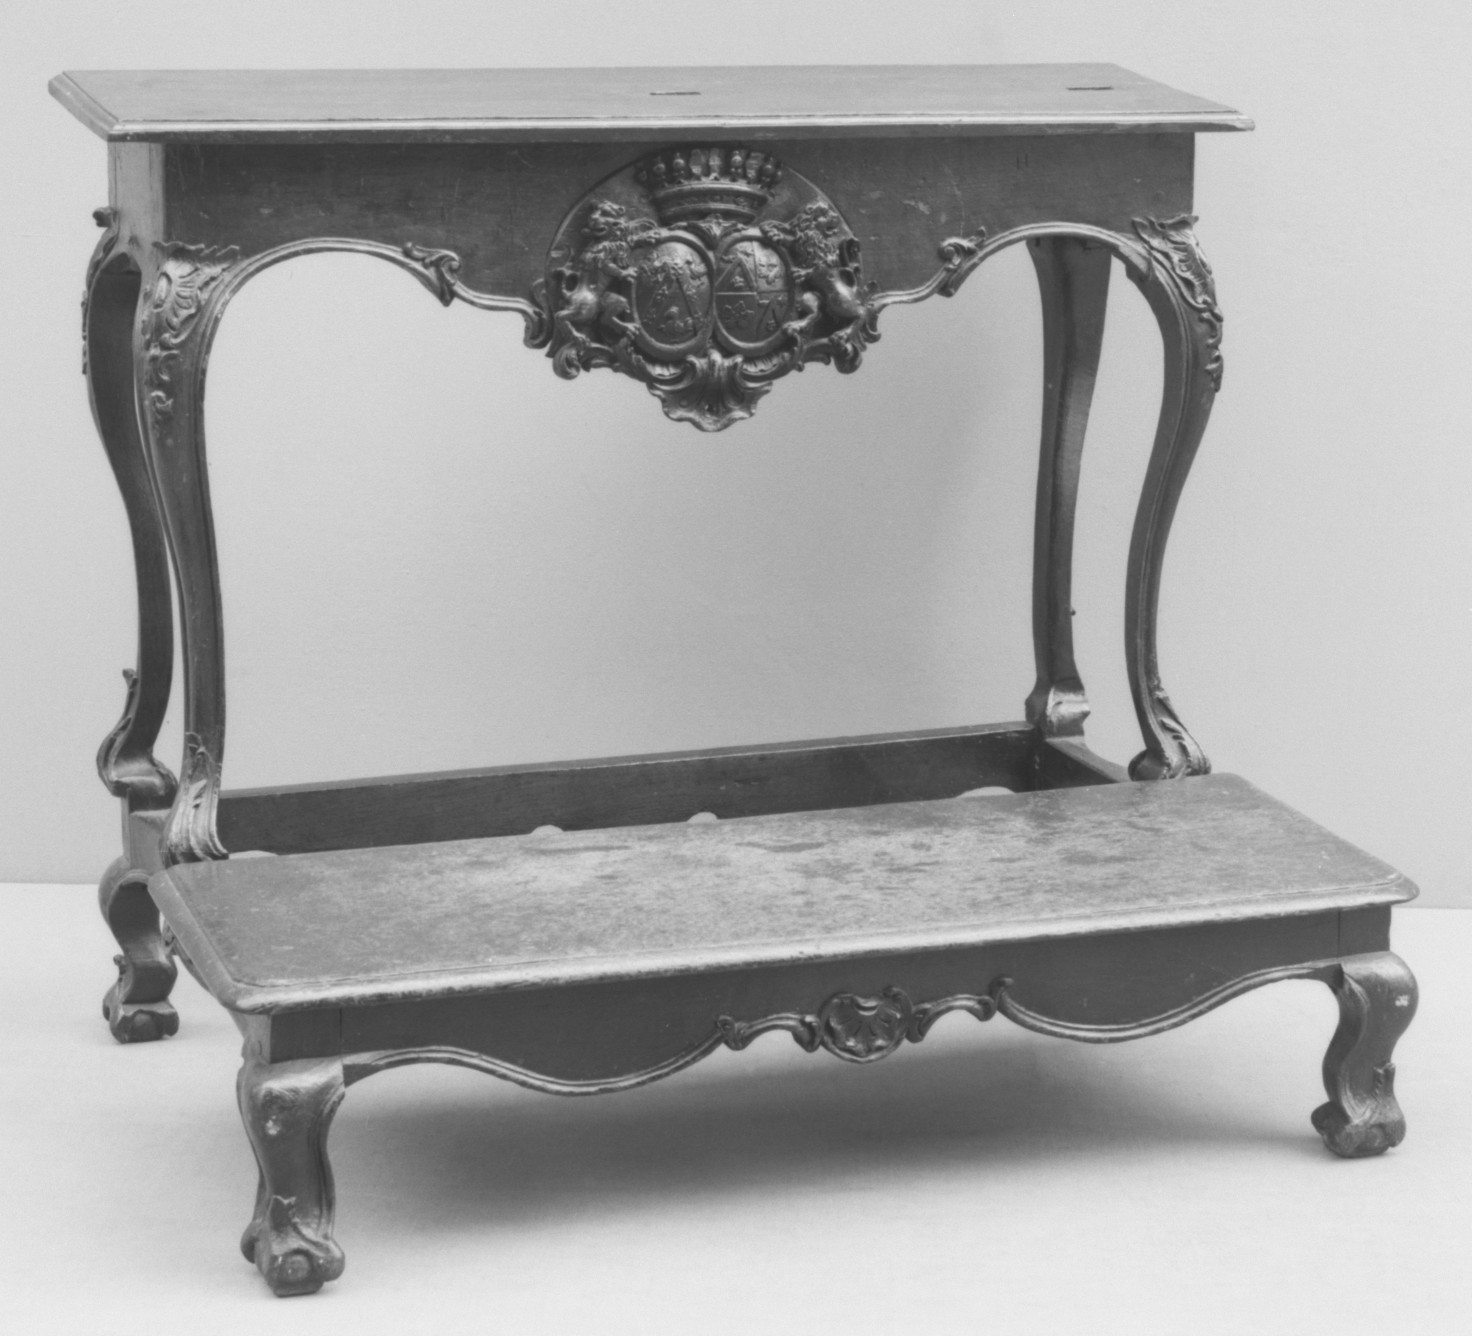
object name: prie dieu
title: Prie-dieu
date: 1734-1766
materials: wood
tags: coat of arms